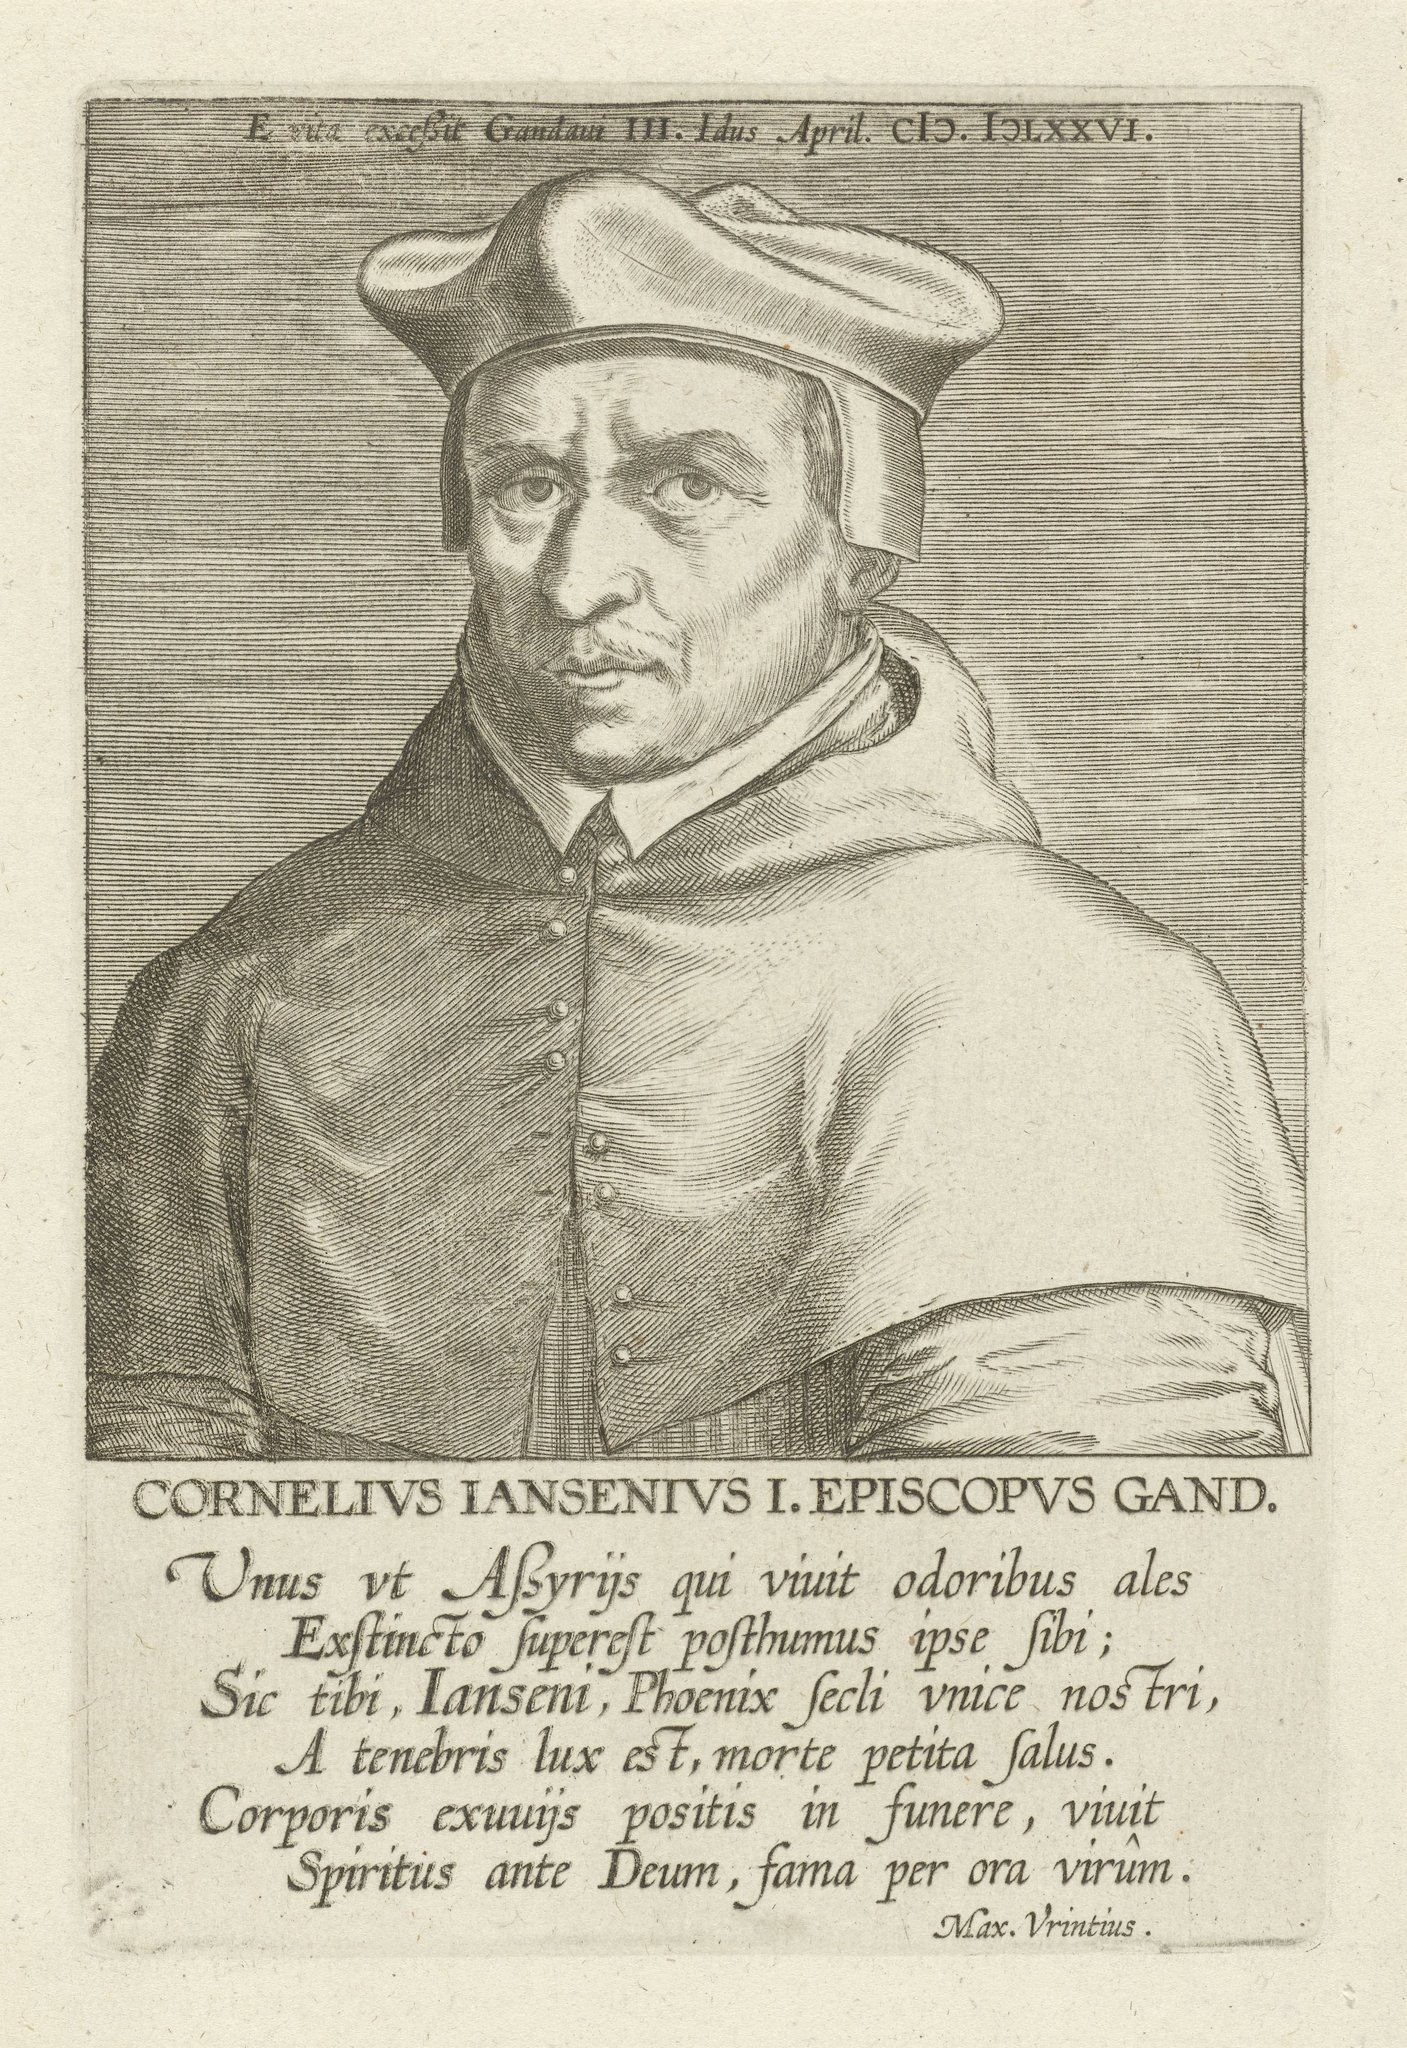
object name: print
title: Bekende schrijvers uit de Nederlanden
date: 1608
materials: paper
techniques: engraving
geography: ghent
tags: louvain, priest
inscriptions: collector's mark: Lugt 2228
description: Portret van Cornelius Jansenius, eerste bisschop van Gent. Buste naar links. De prent heeft een Latijns boven- en onderschrift en maakt deel uit van een serie van bekende schrijvers uit de Nederlanden.